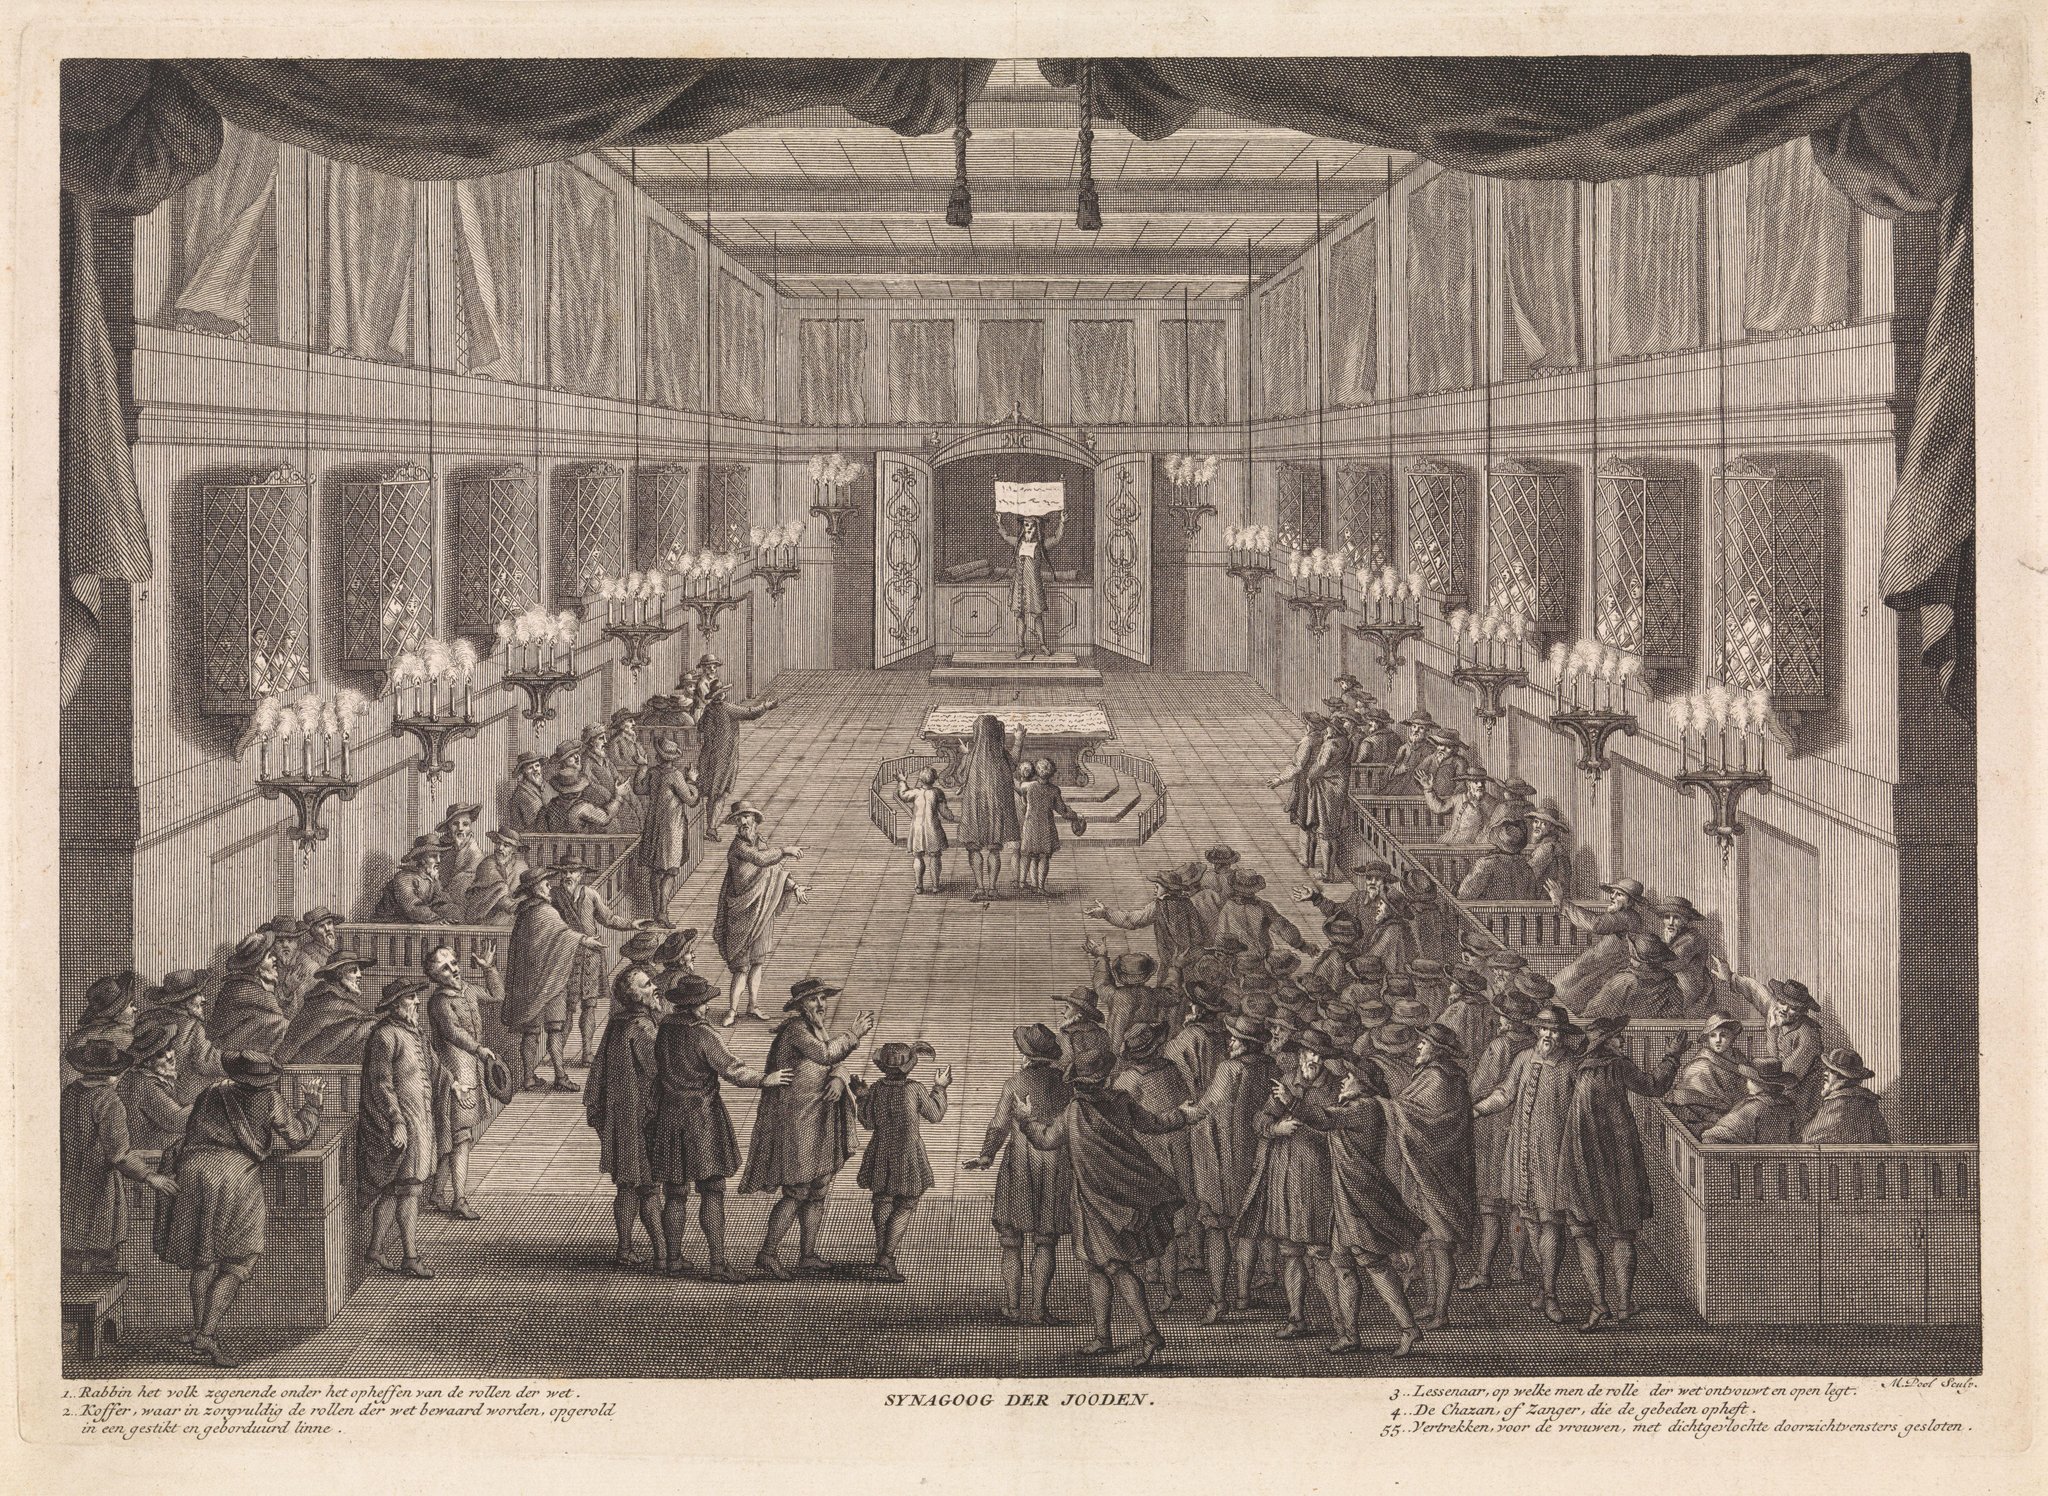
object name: print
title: Interieur van een Joodse synagoge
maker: matthijs pool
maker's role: print maker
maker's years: 1676-1740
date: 1686-1727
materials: paper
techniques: engraving, etching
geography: amsterdam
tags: the synagogue (as building and place of worship ~ jewish religion)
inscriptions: collector's mark: Lugt 2228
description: Interieur van een Joodse synagoge. Op de voorgrond de mannelijke gelovigen. Aan weerszijden van de ruimte de vensters van de vrouwenvertrekken. Op de achtergrond de rabbijn die de tafelen der wet omhoog houdt. In de marge een legenda in het Nederlands.